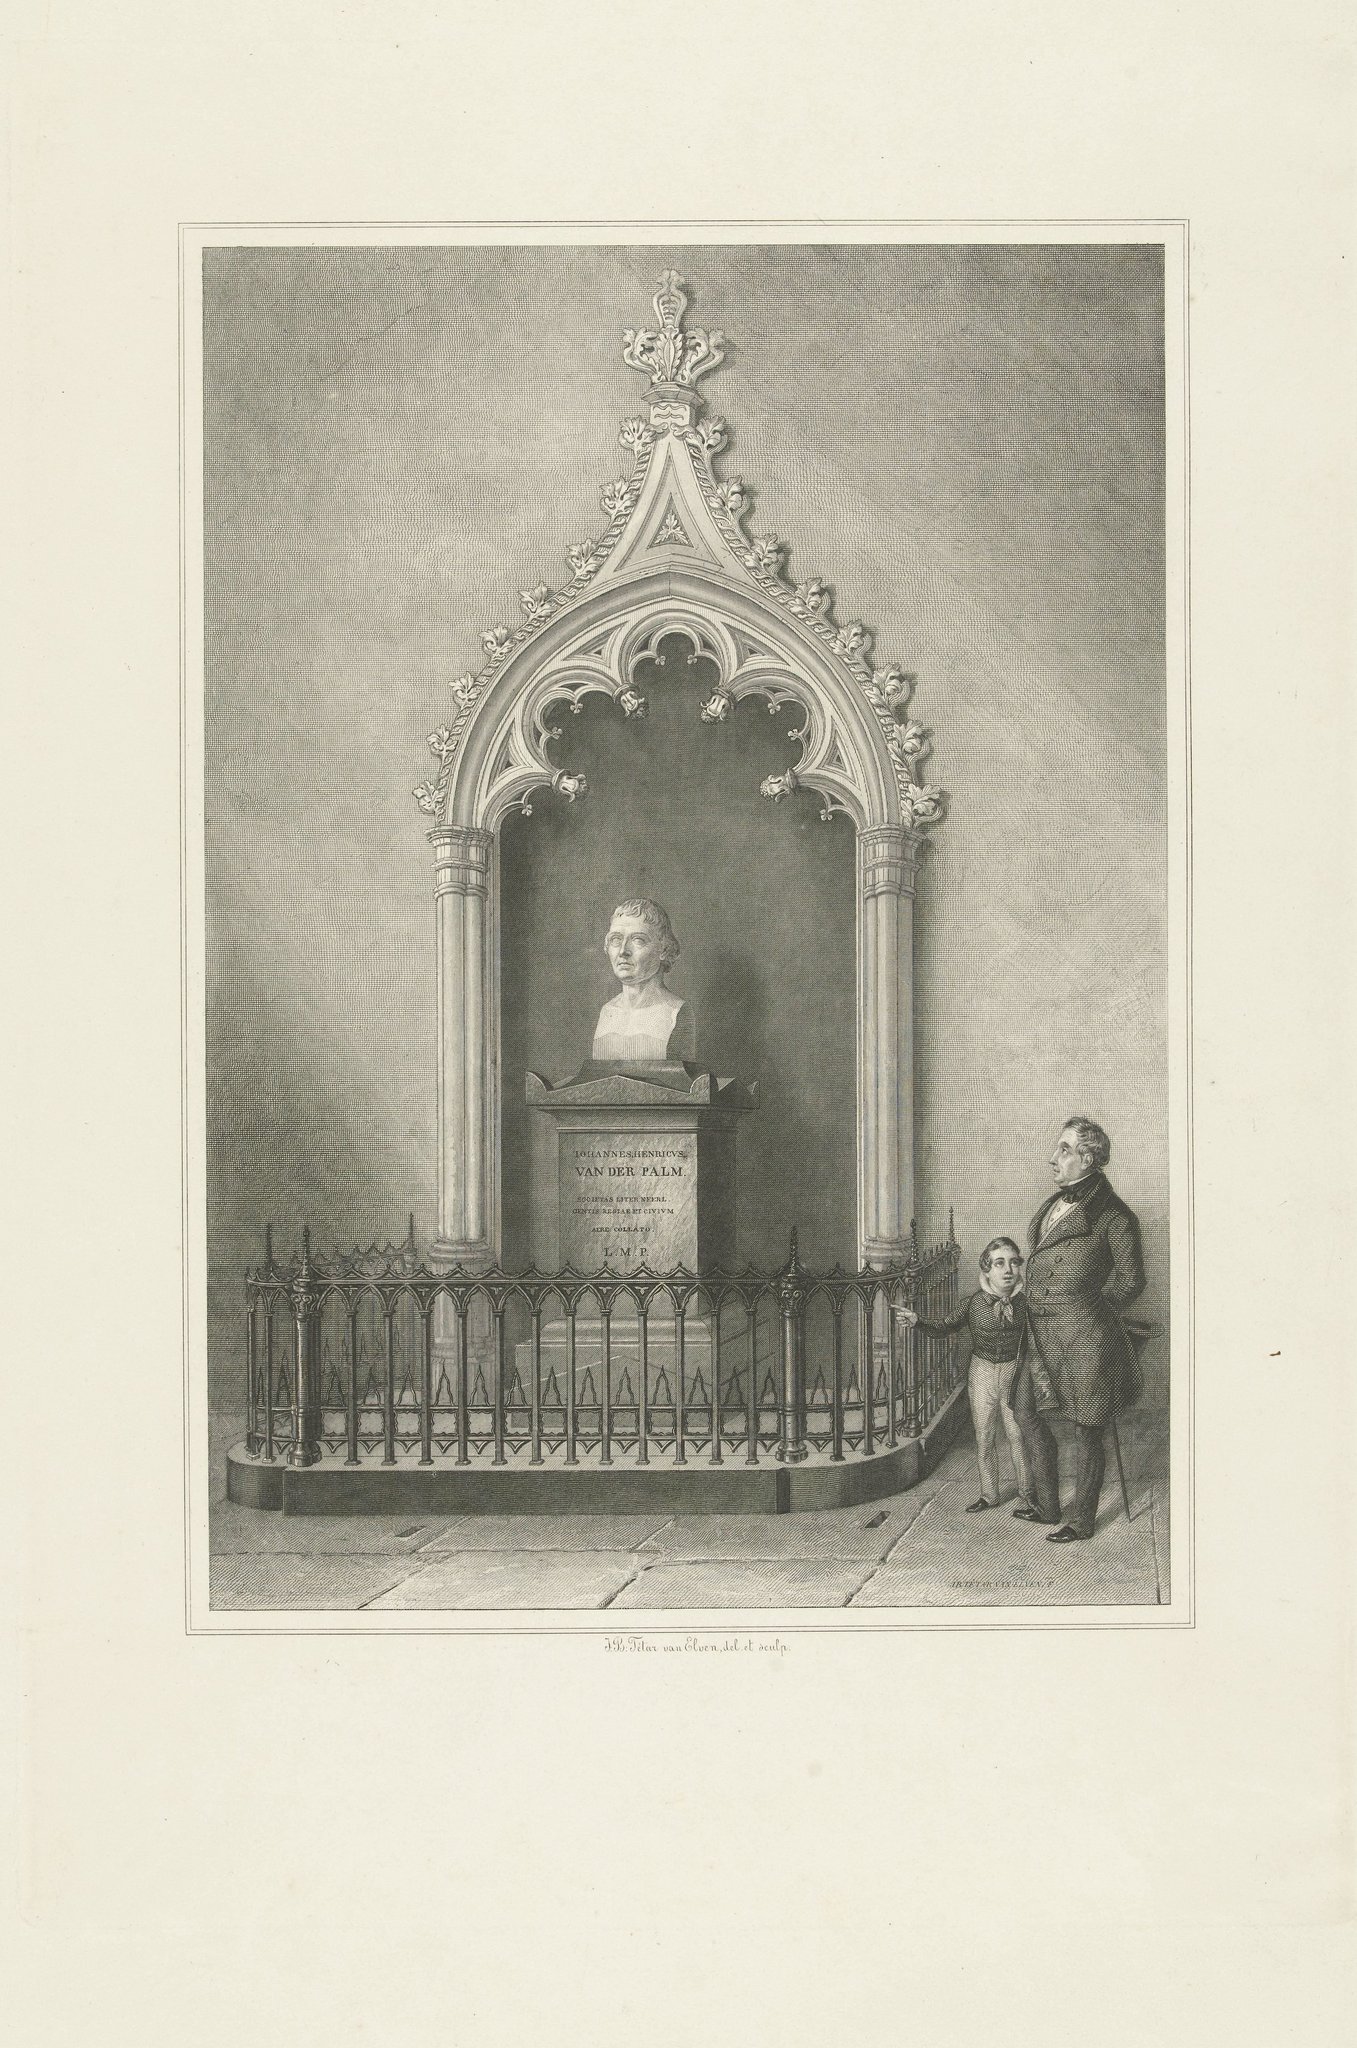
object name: print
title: Monument voor Johannes Henricus van der Palm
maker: jan baptist tetar van elven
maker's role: draughtsman, print maker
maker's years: 1805-1889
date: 1843-1853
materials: paper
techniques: engraving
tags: rotterdam, leiden, johannes hendricus van der palm, grave-building, monumental tomb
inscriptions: collector's mark: Lugt 964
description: Een man en een jongen kijken naar het monument met het borstbeeld van de dichter, theoloog, staatsman en hoogleraar Johannes van der Palm (1763-1840), in de Pieterskerk te Leiden.